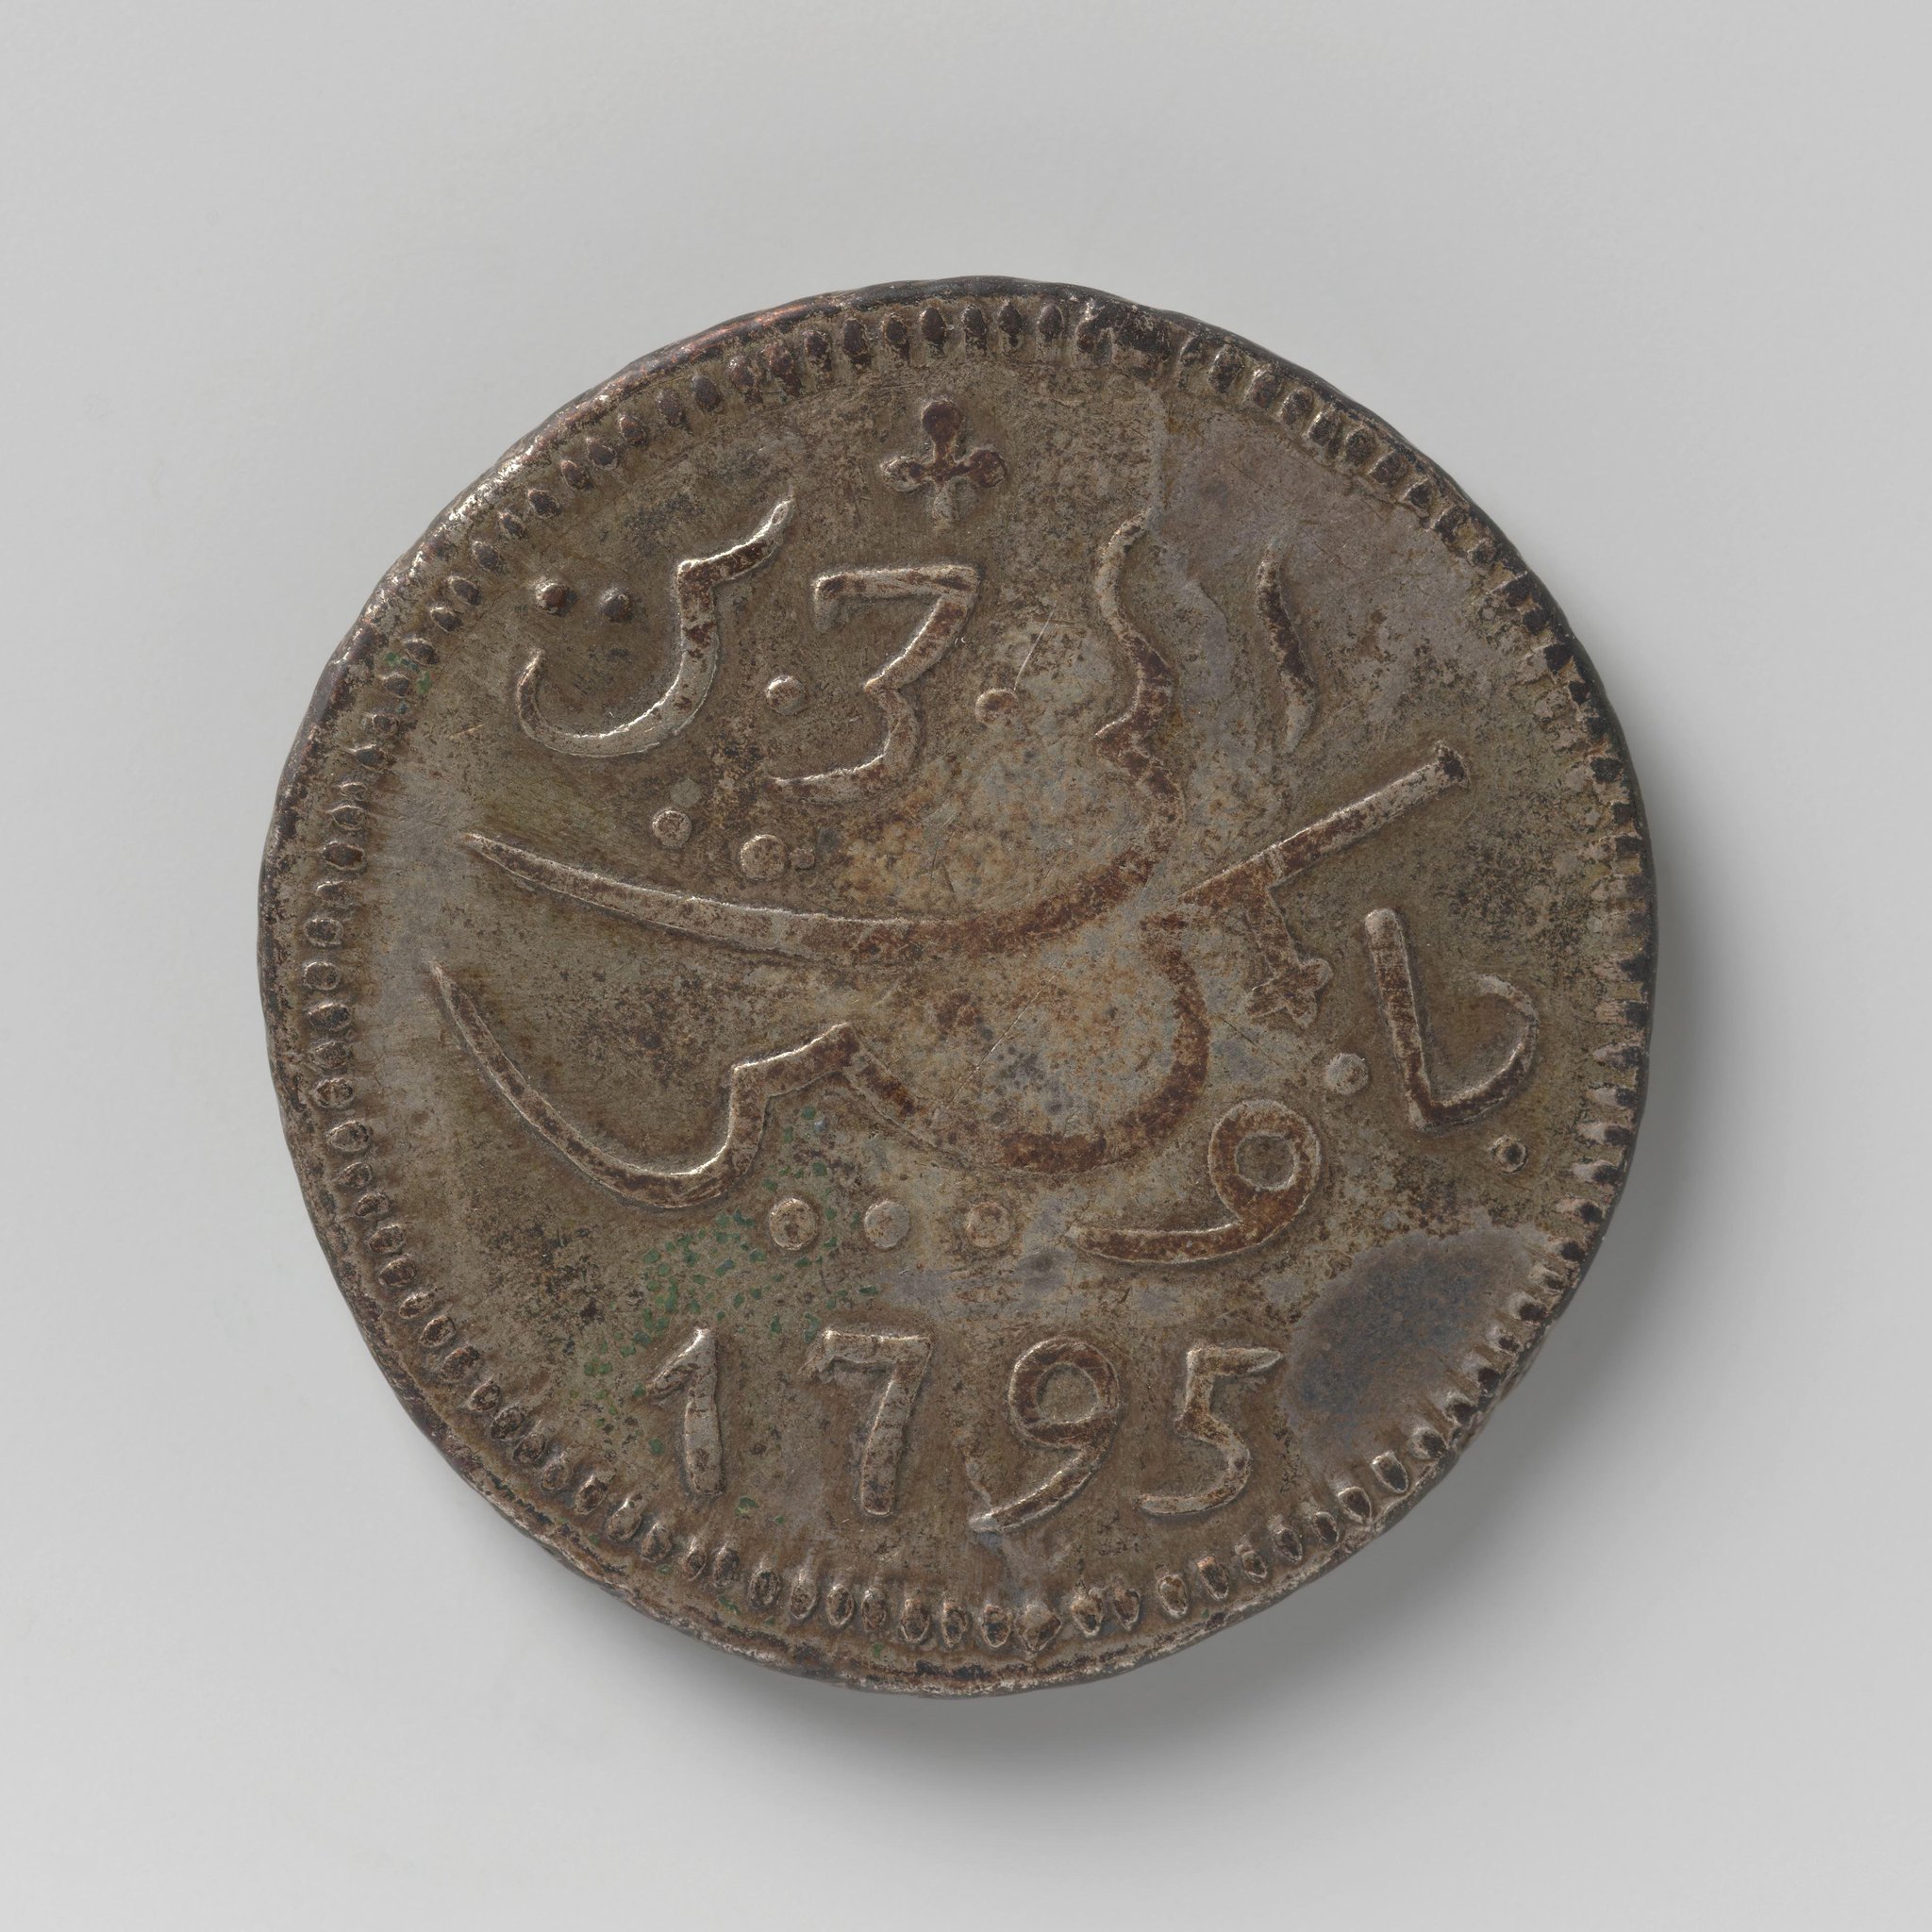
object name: coin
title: Zilveren ropij van de VOC uit Java, 1795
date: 1795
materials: silver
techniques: striking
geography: batavia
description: Zilveren munt. Voorzijde: tweeregelig opschrift in Arabische letters. Daarboven muntteken en daaronder jaartal. Keerzijde: drieregelig opschrift in Arabische letters. Kabelrand.